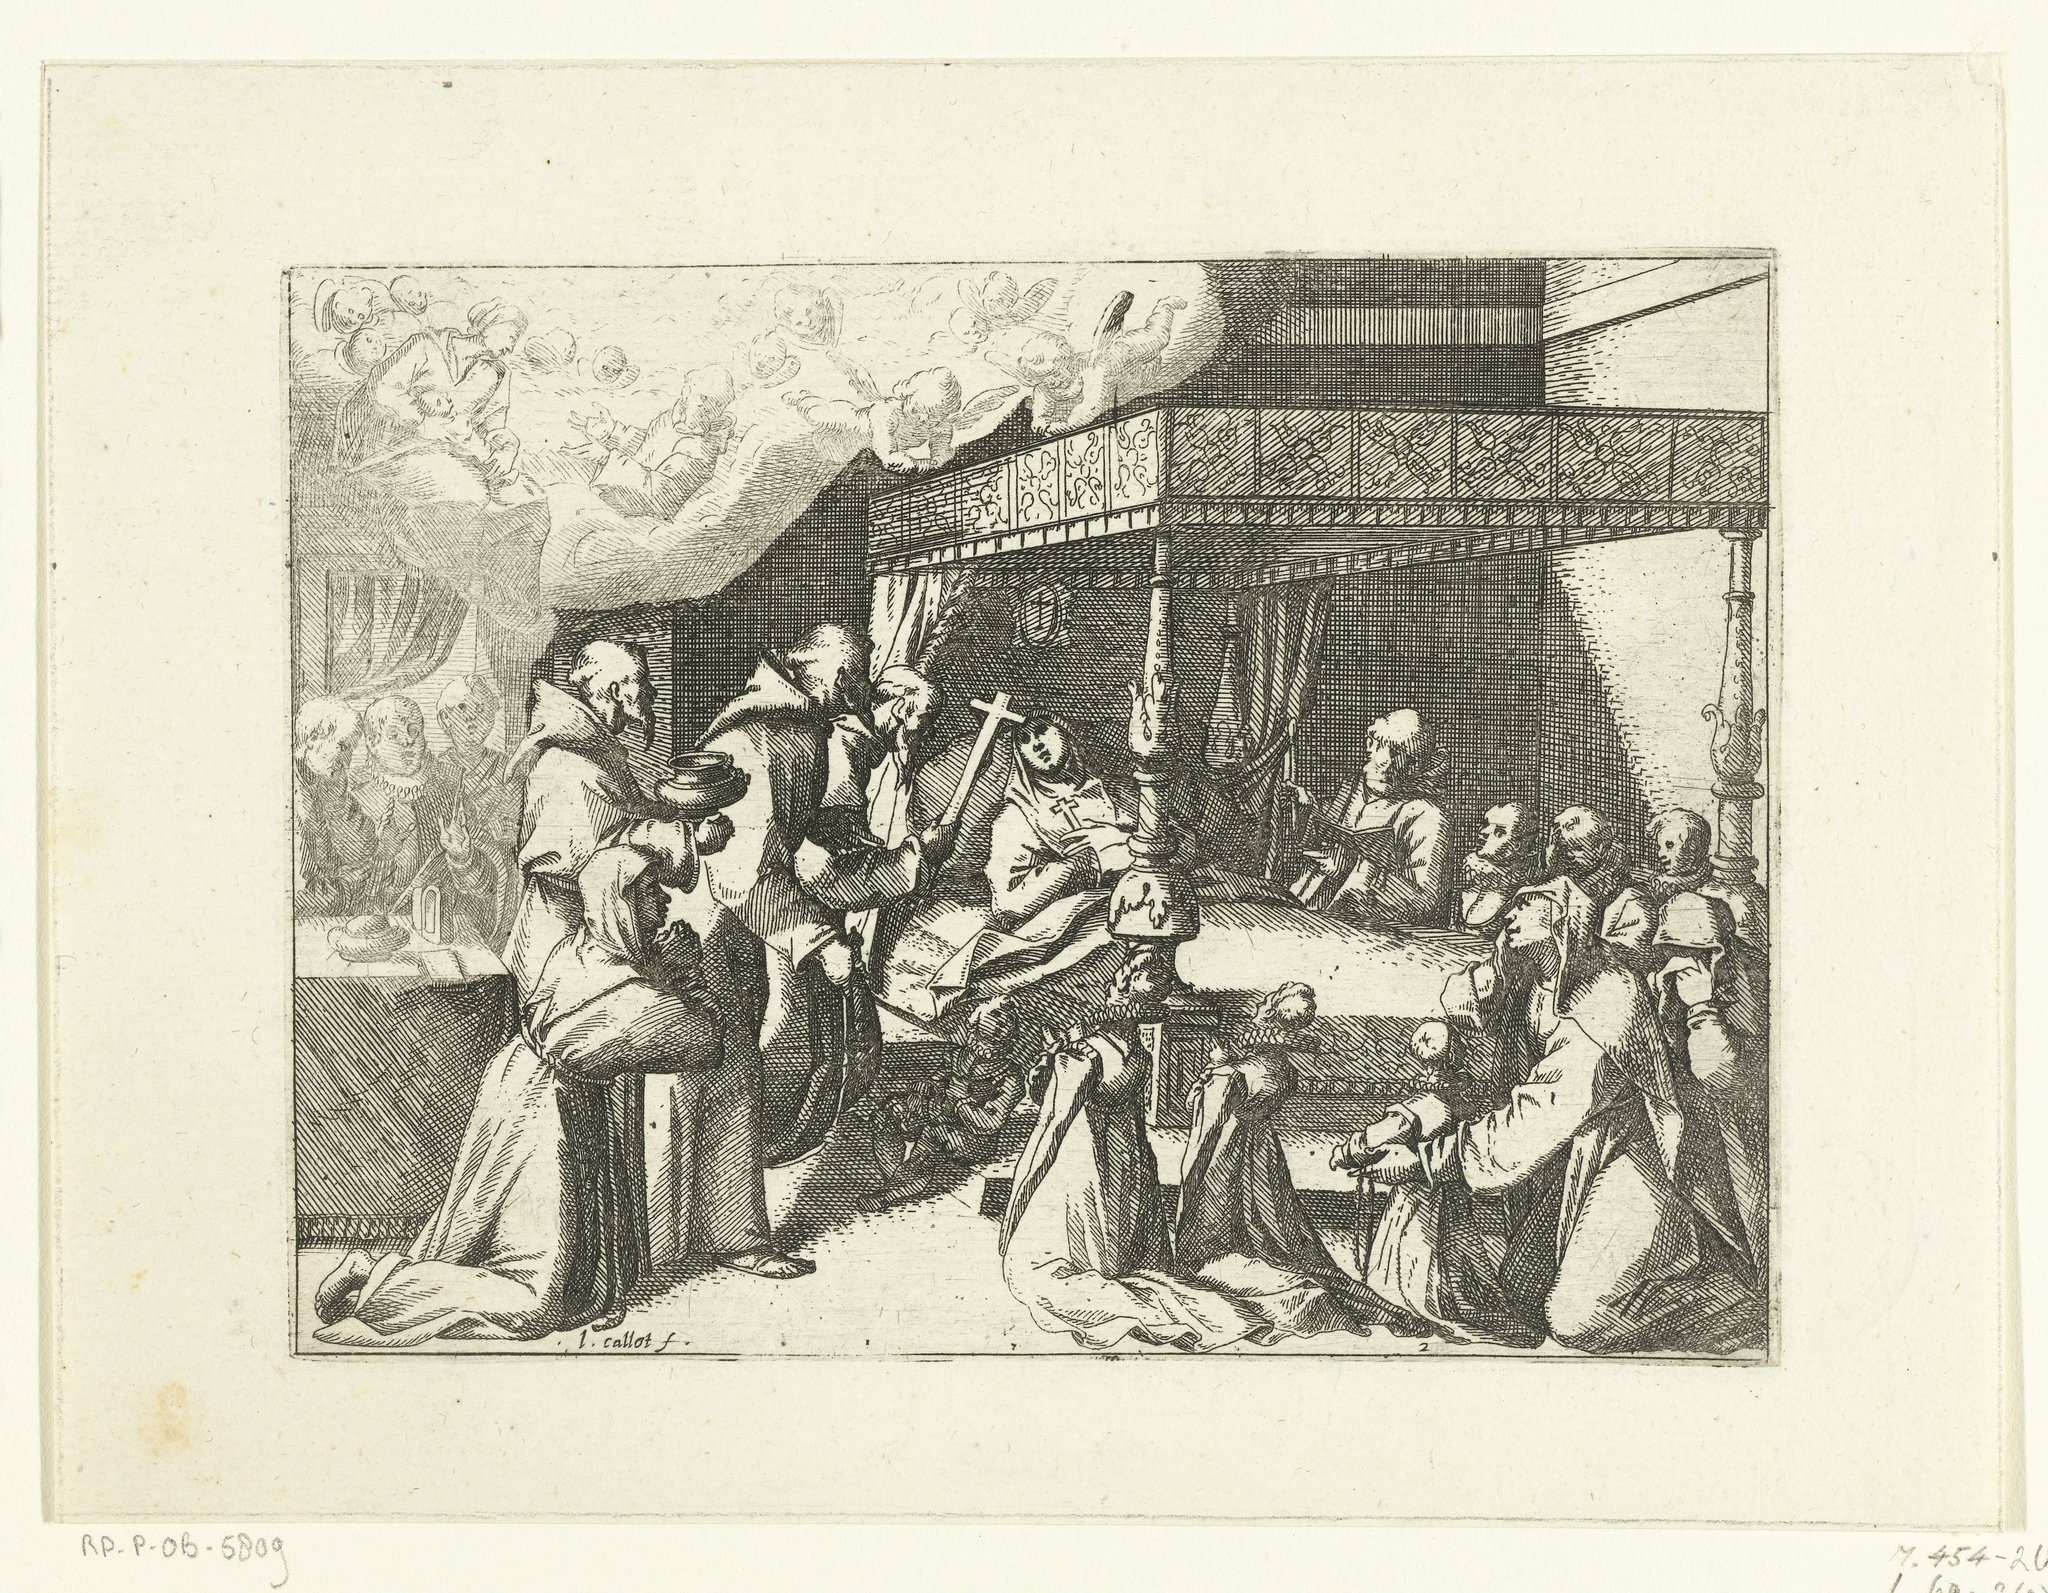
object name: print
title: De dood van Margaretha van Oostenrijk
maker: jacques callot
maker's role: draughtsman, print maker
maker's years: 1592-1635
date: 1612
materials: paper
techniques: etching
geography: florence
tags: margaretha van oostenrijk (koningin van spanje), deathbed, angels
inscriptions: collector's mark: Lugt 240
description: Margaretha van Oostenrijk ligt in een groot hemelbed, omringd door kinderen en geestelijken. Links, veel vager dan de rest van de voorstelling, drie mannen aan een tafel, een vrouw met een kind (Maria?) en een geestelijke (God? Petrus?) te midden van engeltjes.